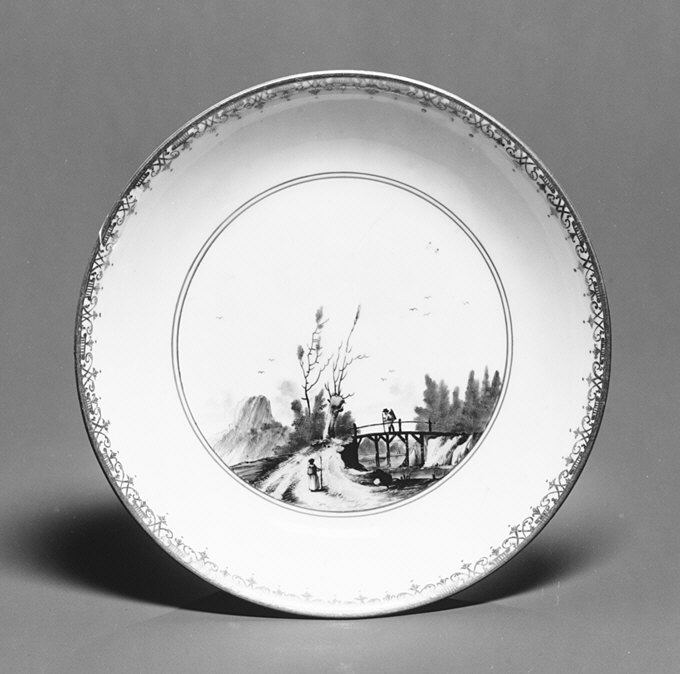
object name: saucer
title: Saucer (part of a service)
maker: meissen manufactory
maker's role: manufactory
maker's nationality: german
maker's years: 1710-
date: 1701-1800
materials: hard paste porcelain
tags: bridges,landscapes